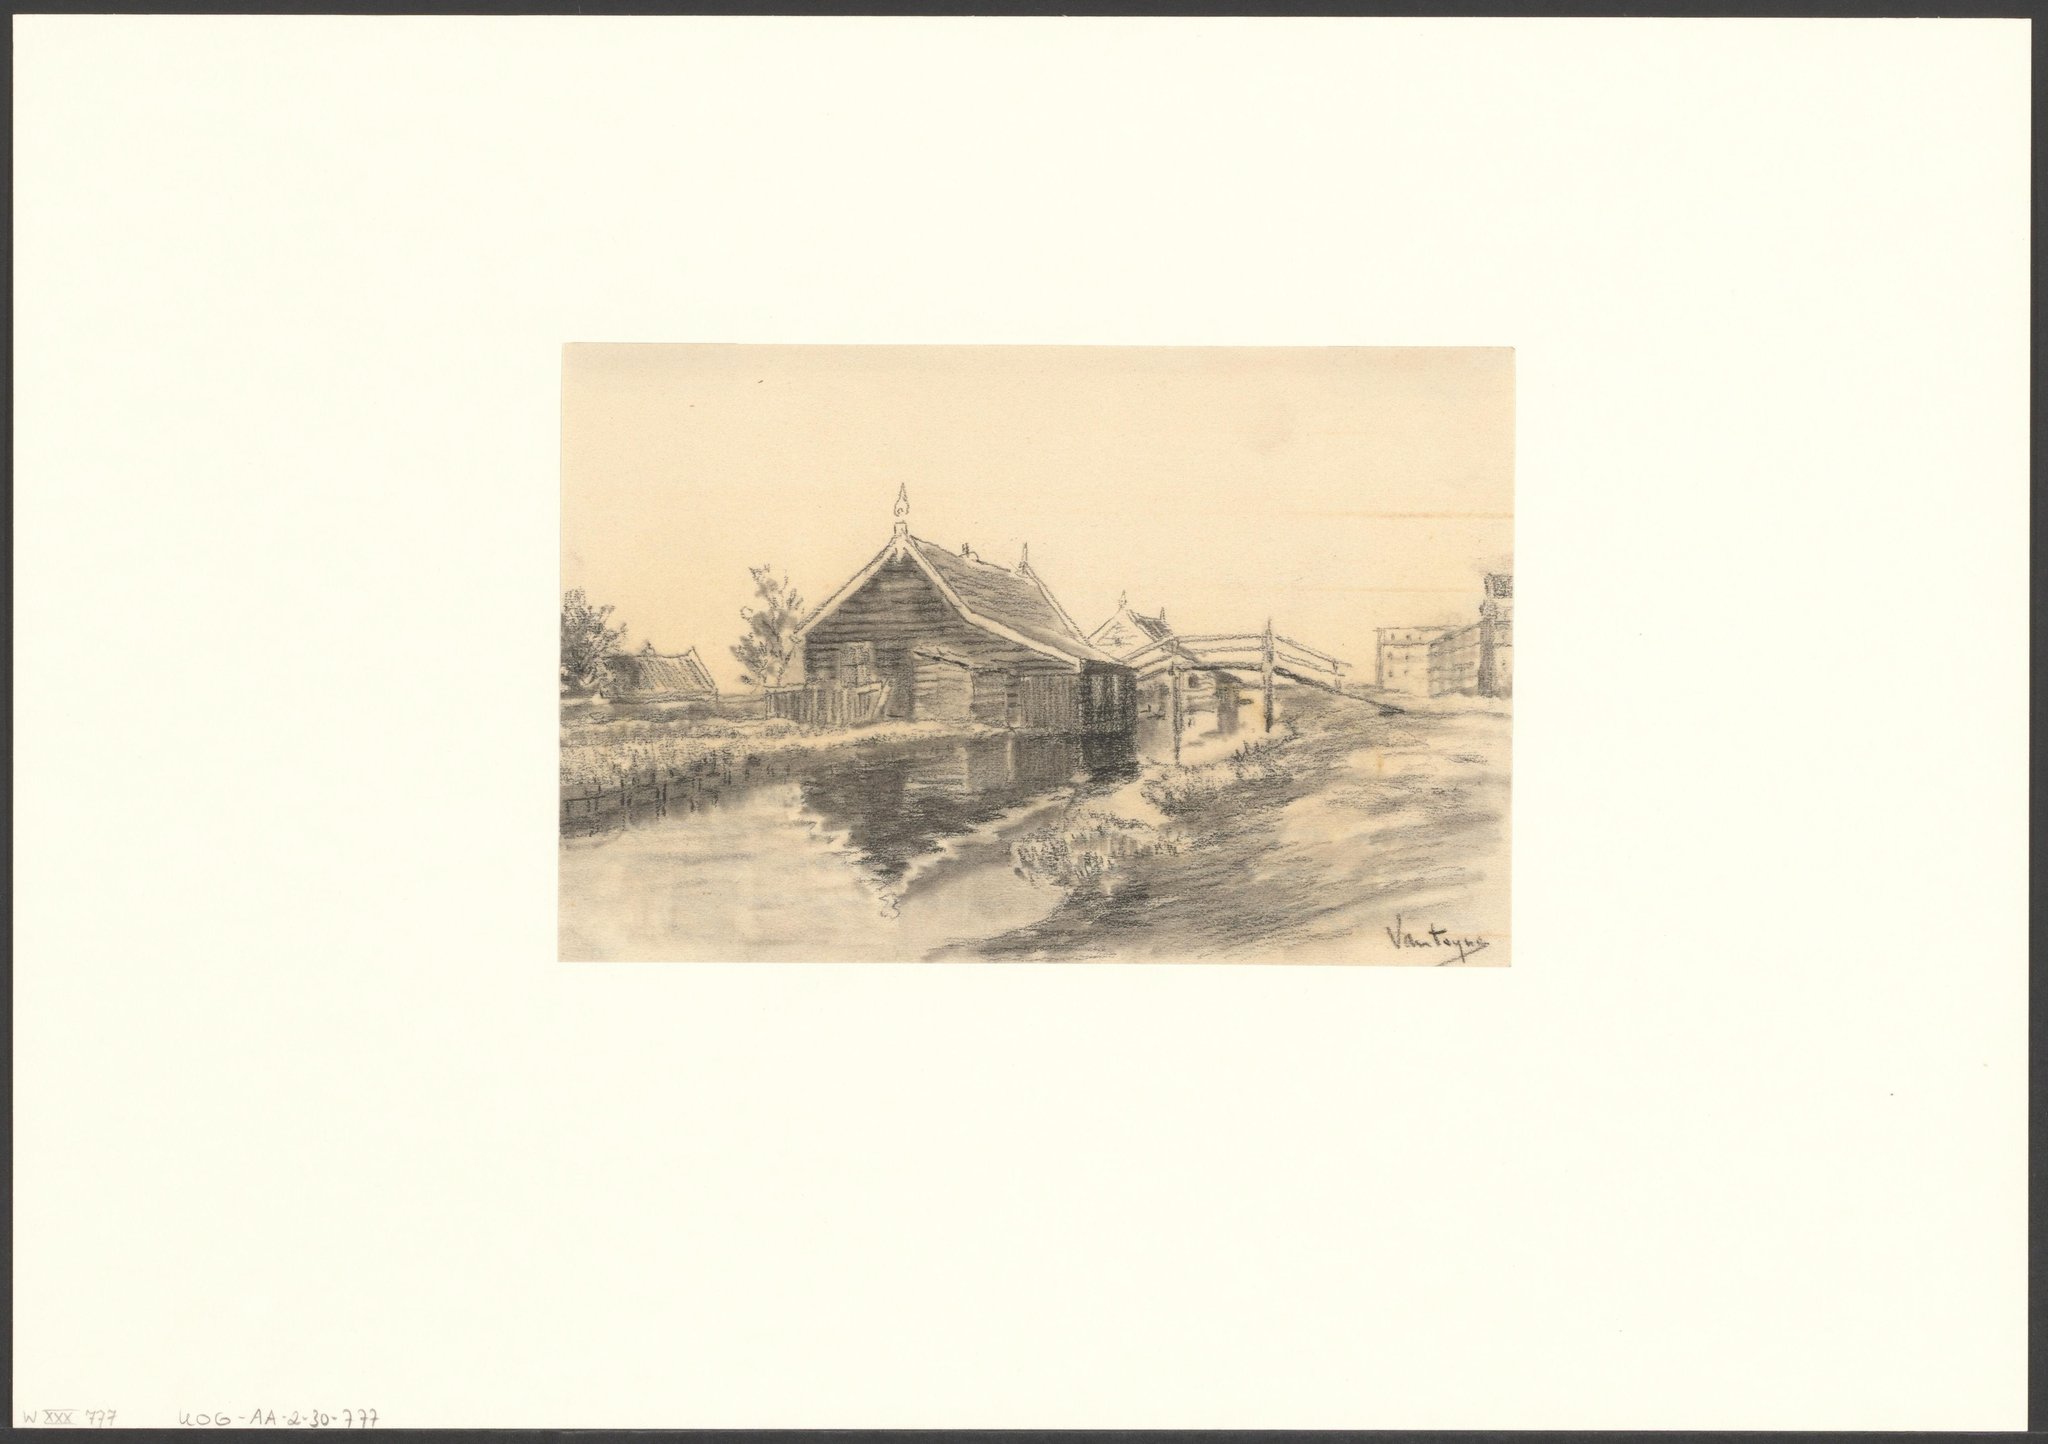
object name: drawing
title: Gezicht op de Warmoestuinen nabij de Van Spilbergenstraat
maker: anthonie van teijn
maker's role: draughtsman, painter, print maker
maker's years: 1863-1943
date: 1910-1927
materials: chalk, paper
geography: amsterdam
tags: city-view in general; 'veduta', canal, bridge in city across river, canal, etc., farm or solitary house in landscape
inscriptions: collector's mark: Lugt 800a, signature: ‘VanTeyne’, inscription: ‘Groenten tuinen na (...) Oct 1927. vEck’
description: Tekening binnen de Atlas Van Eck ingedeeld op wijknummer 30.